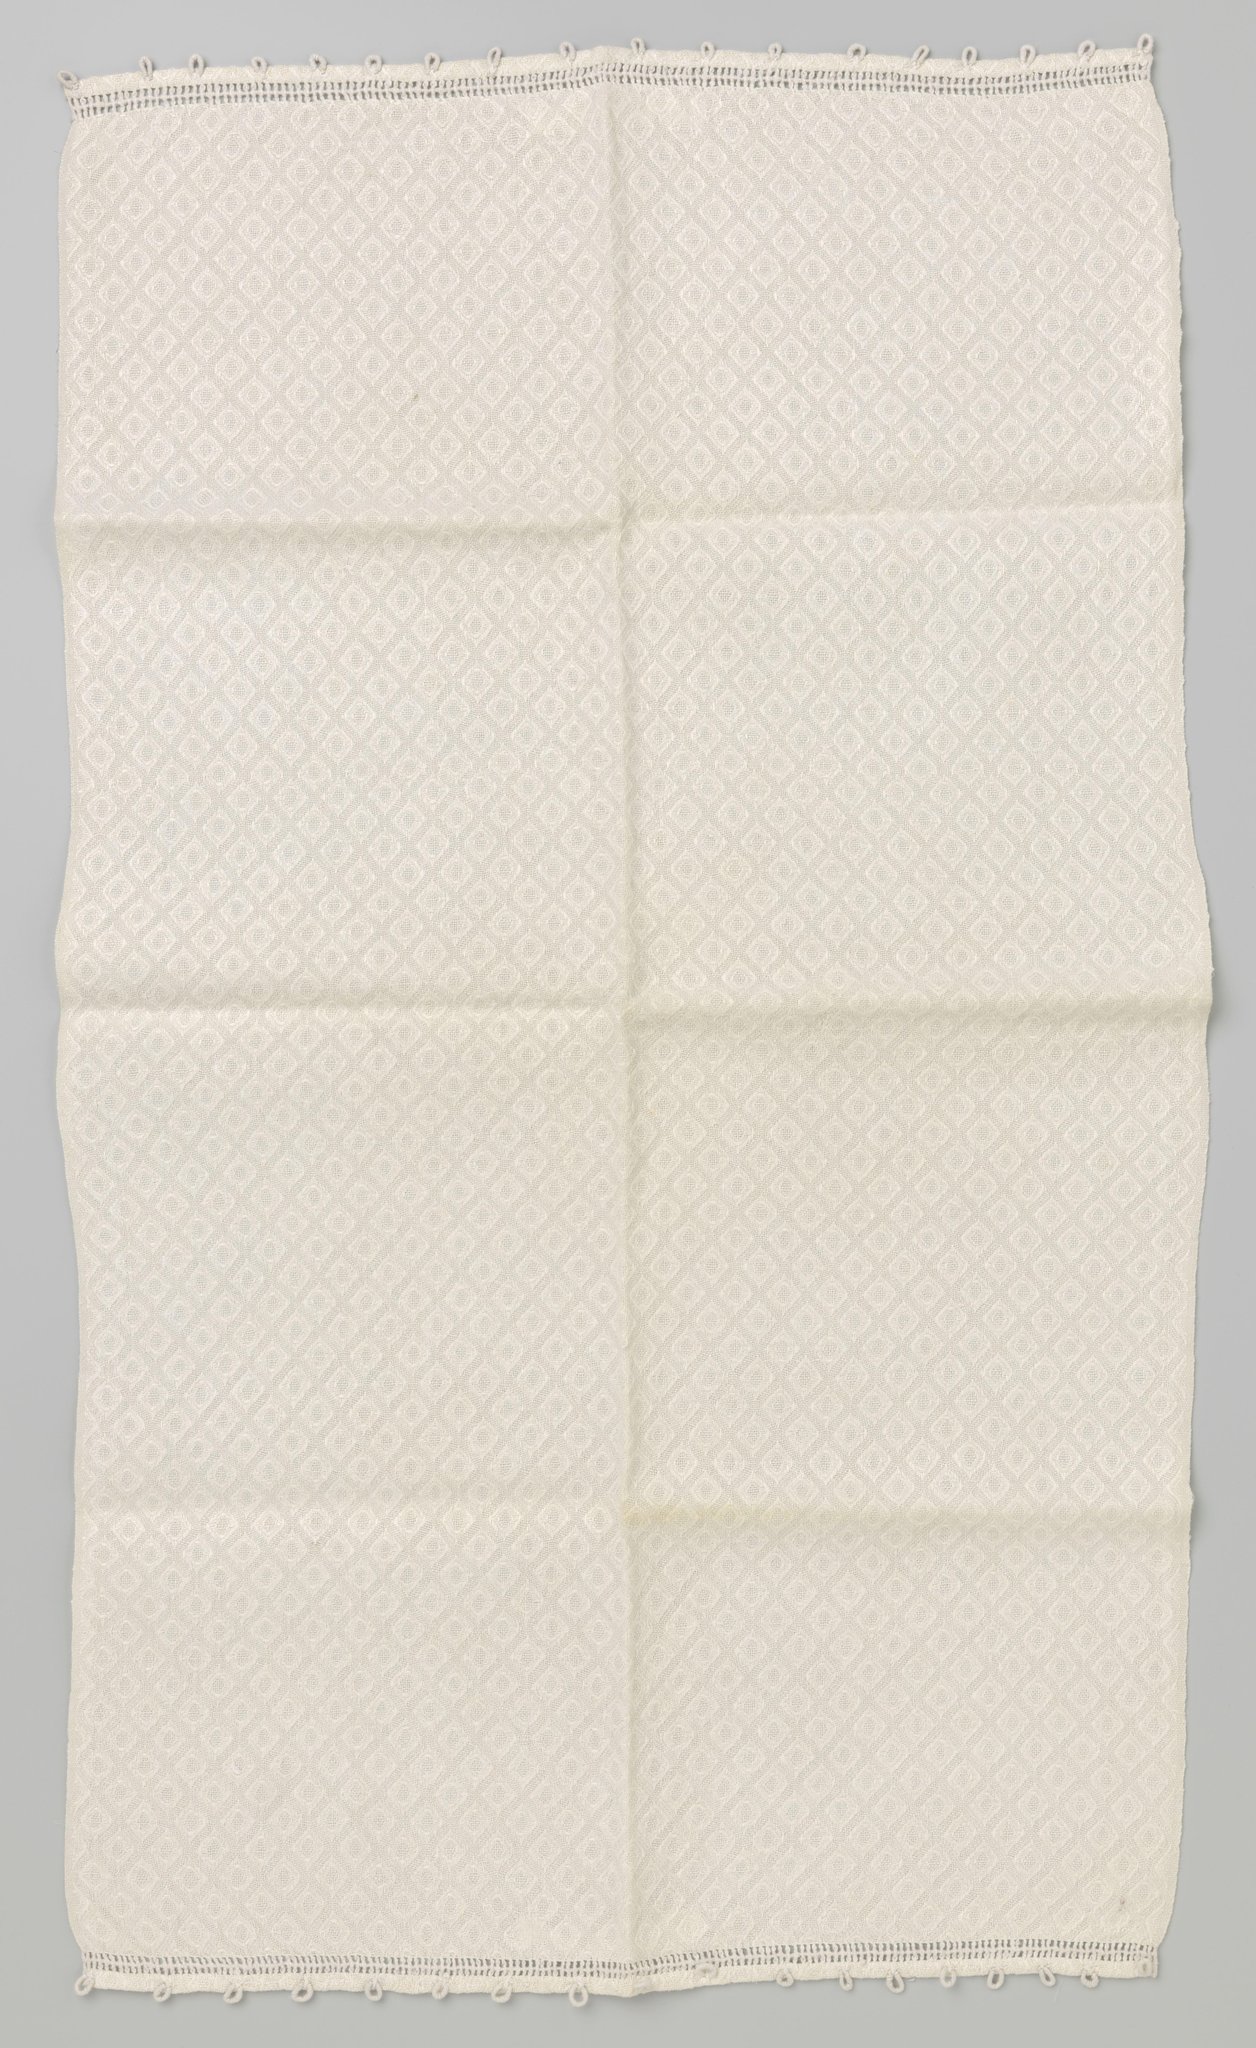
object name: towel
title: Handdoek van grof linnen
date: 1925-1950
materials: linen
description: Handdoek van grof linnen met een rasterwerkpatroon in reliëf en boven en onder met open zomen, versierd met grote picots; in rood gemerkt: Emmens en 8. Zie: BK-1972-169-b.